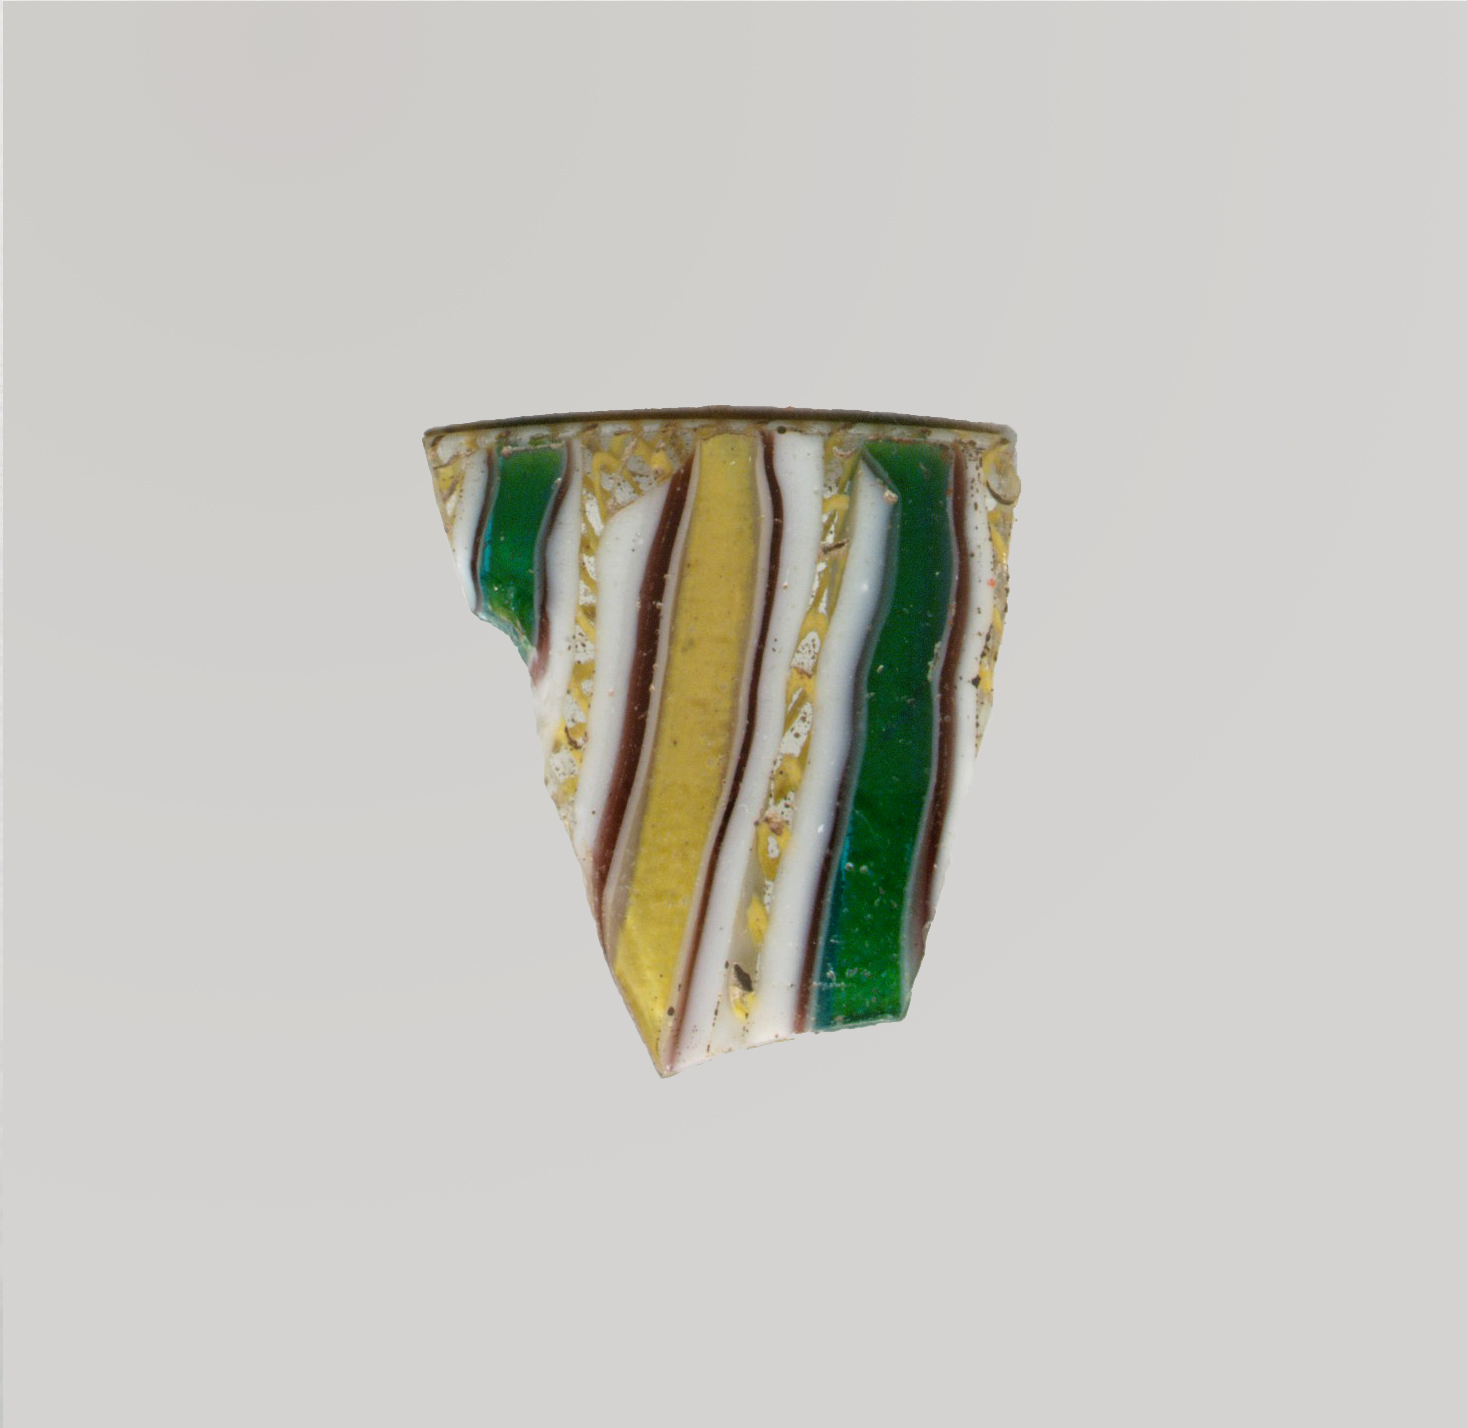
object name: fragment, striped mosaic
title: Glass striped mosaic fragment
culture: roman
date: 34 BCE-33 CE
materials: glass